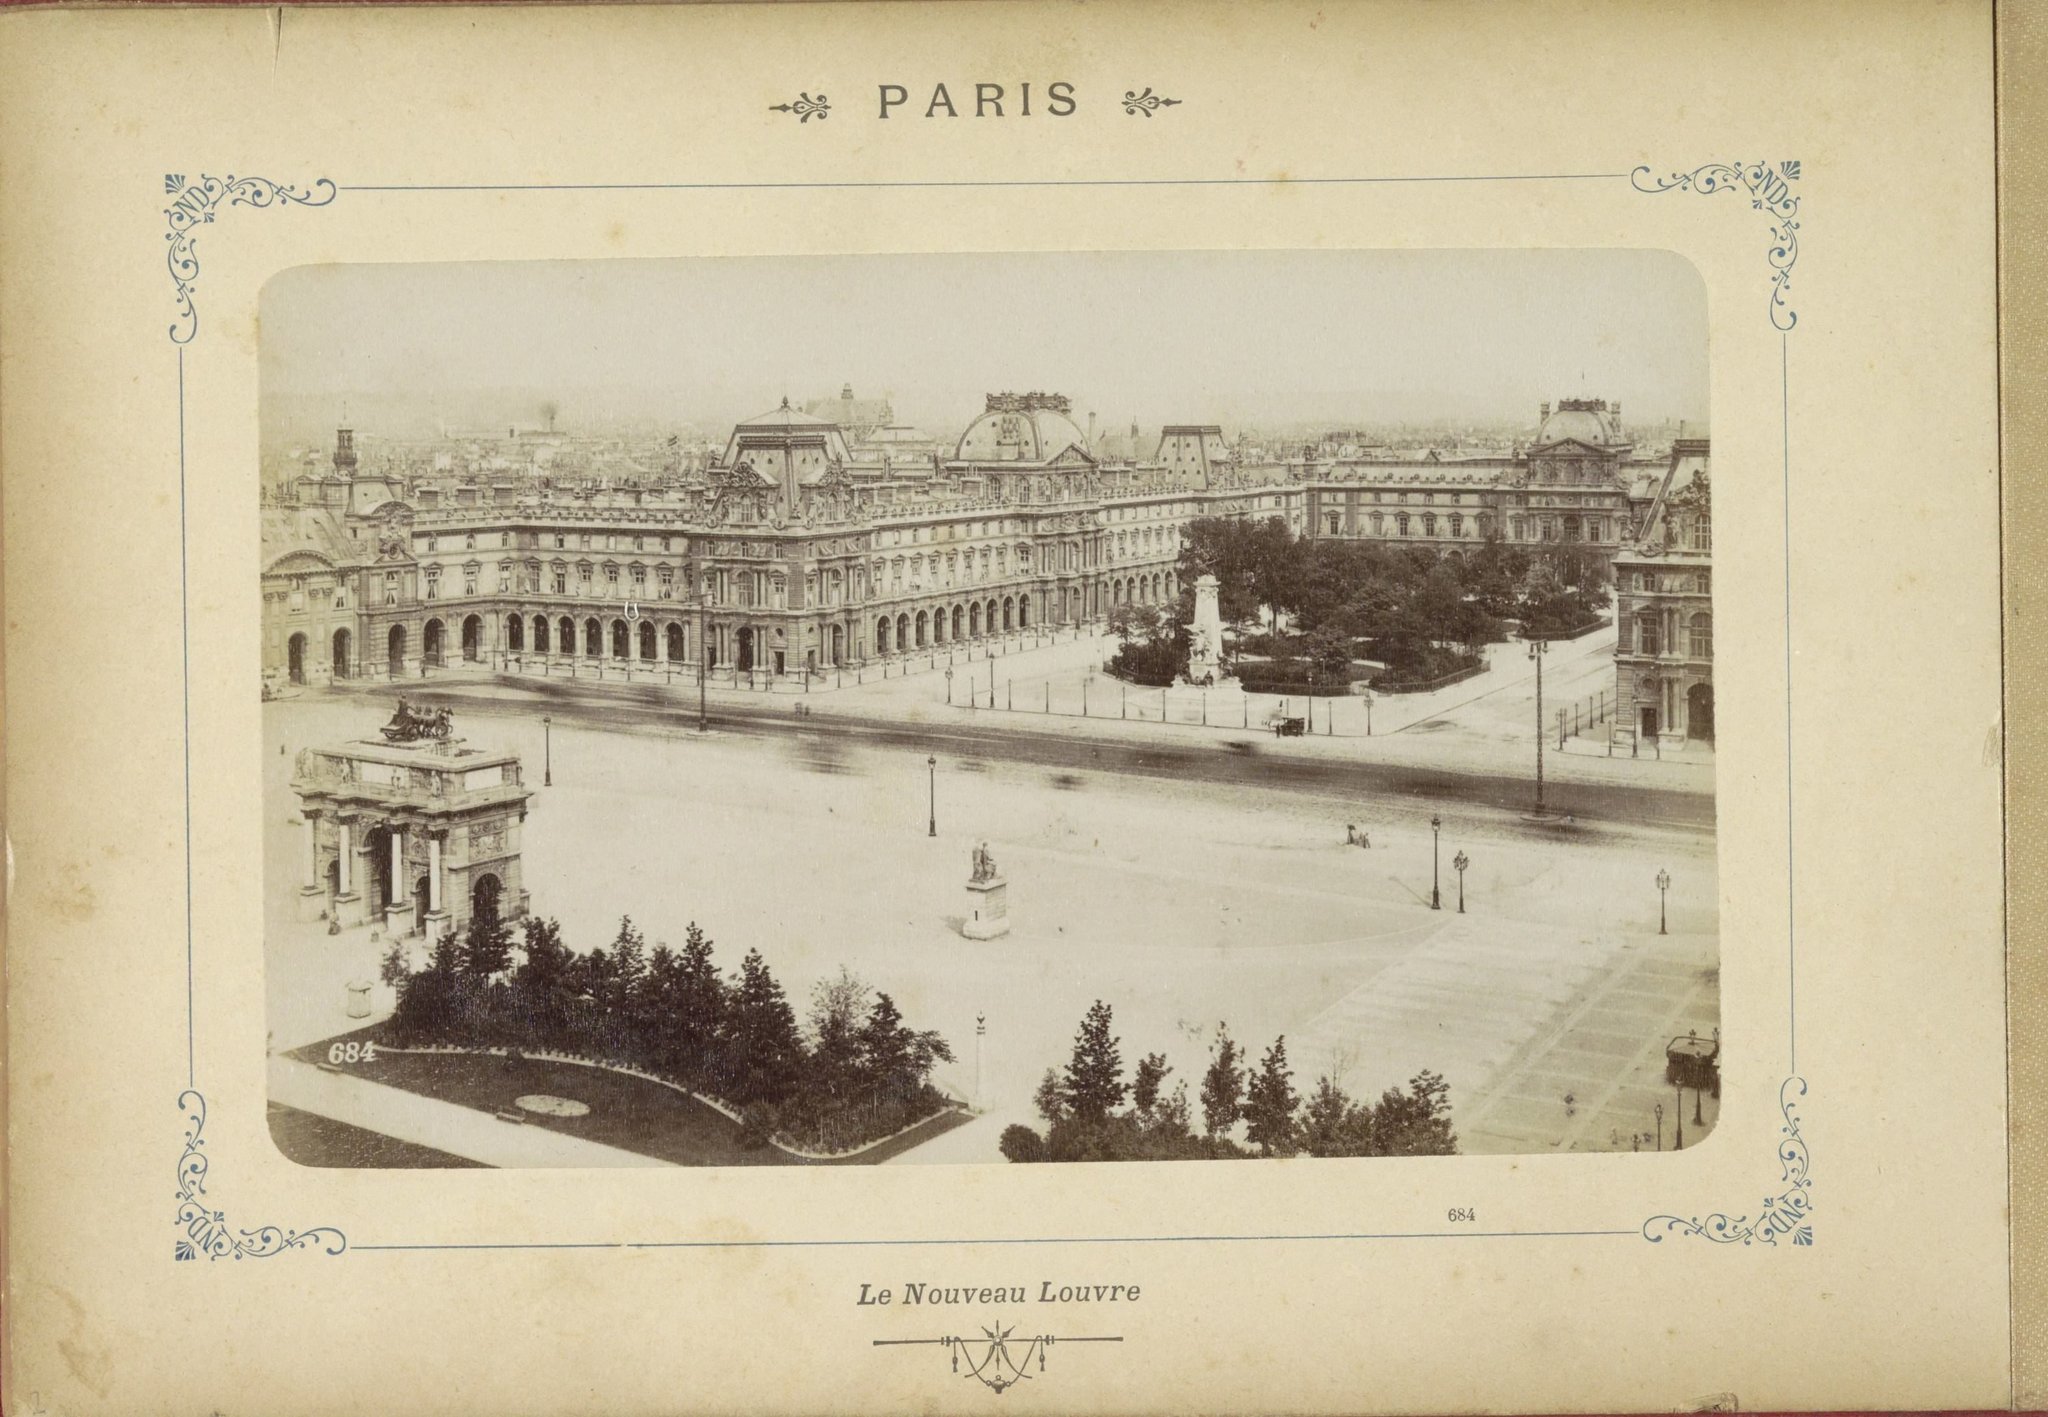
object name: photograph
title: Gezicht op het verbouwde Louvre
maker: Anonymous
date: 1900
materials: cardboard, paper, photographic support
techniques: albumen print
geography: paris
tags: permanent exhibition, museum, square, place, circus, etc. (+ city(-scape) with figures, staffage), paris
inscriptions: number: ‘684’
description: Onderdeel van Fotoalbum met bezienswaardigheden in Parijs, Versailles en het Bois de Boulogne.